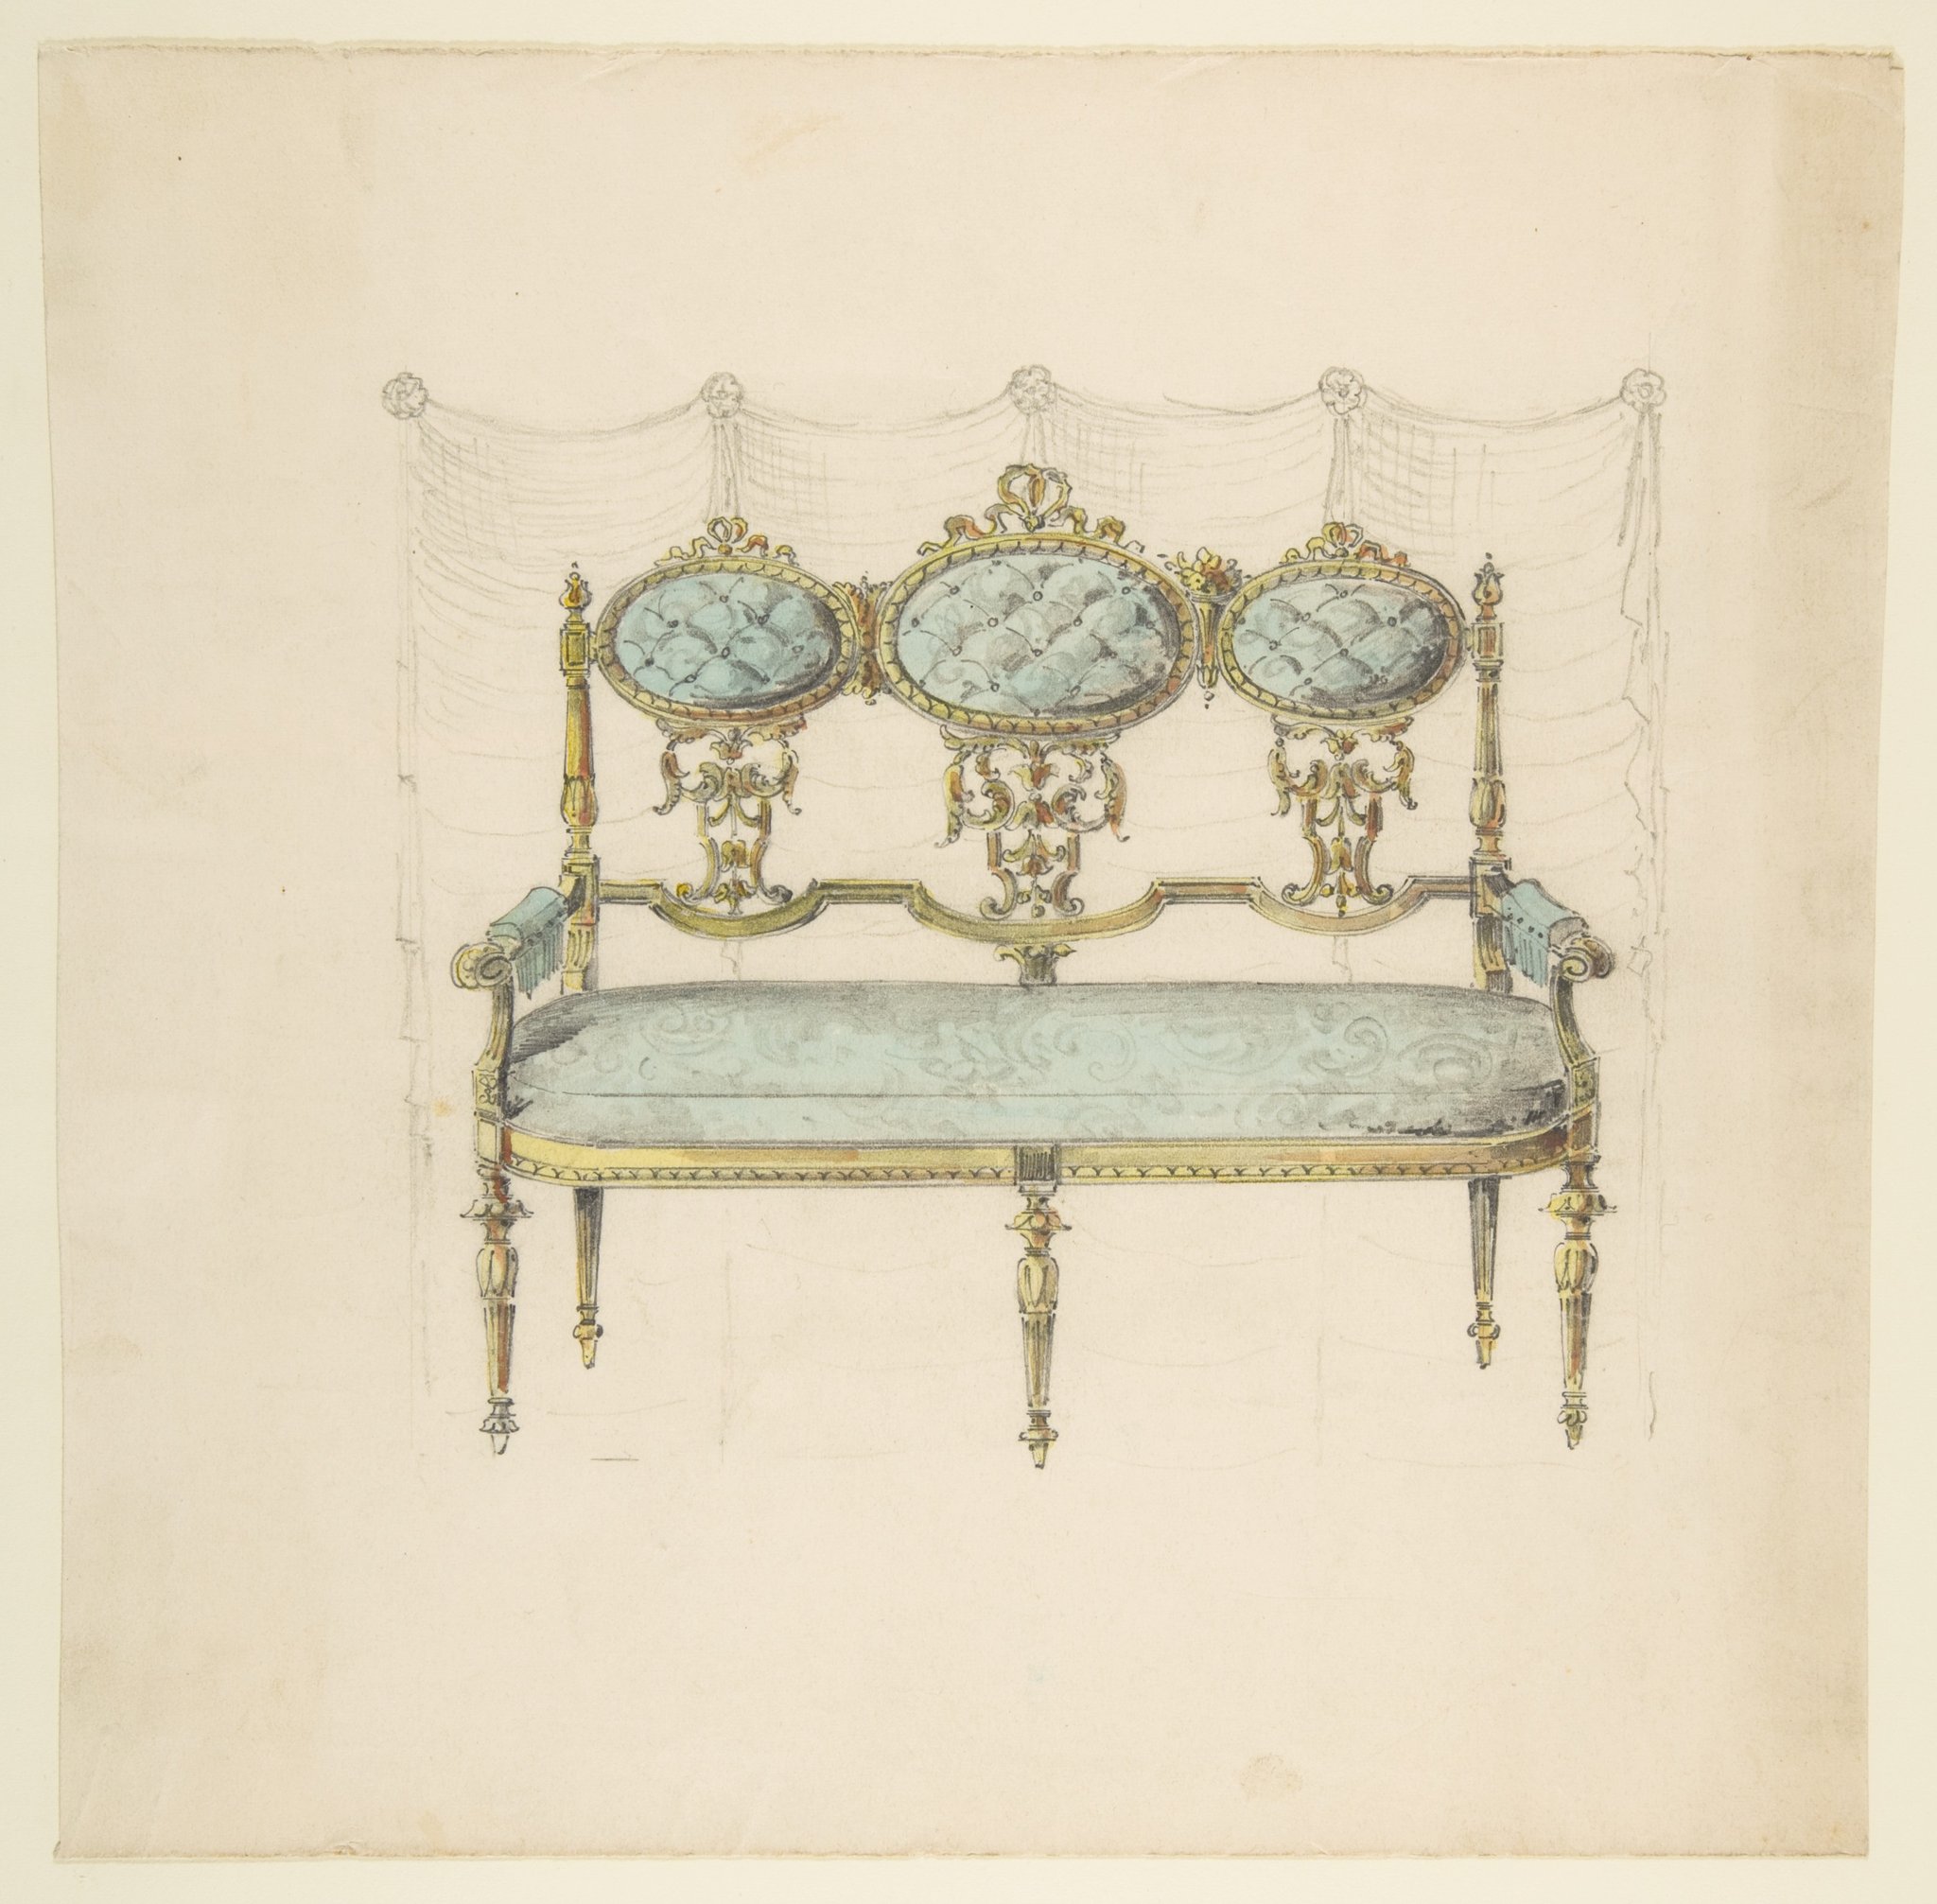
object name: drawing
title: Design for a Settee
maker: anonymous, french, 19th century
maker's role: artist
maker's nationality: french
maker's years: 1800-1900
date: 1801-1900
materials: graphite, watercolor, paper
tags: furniture